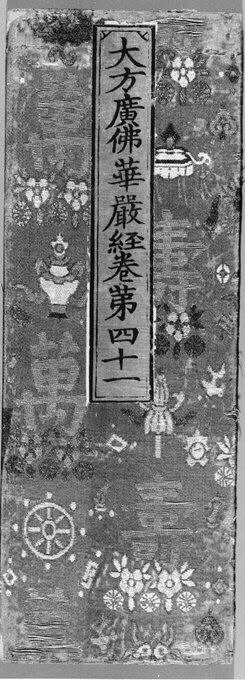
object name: sutra cover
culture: chinese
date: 1601-1700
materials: metal thread, silk